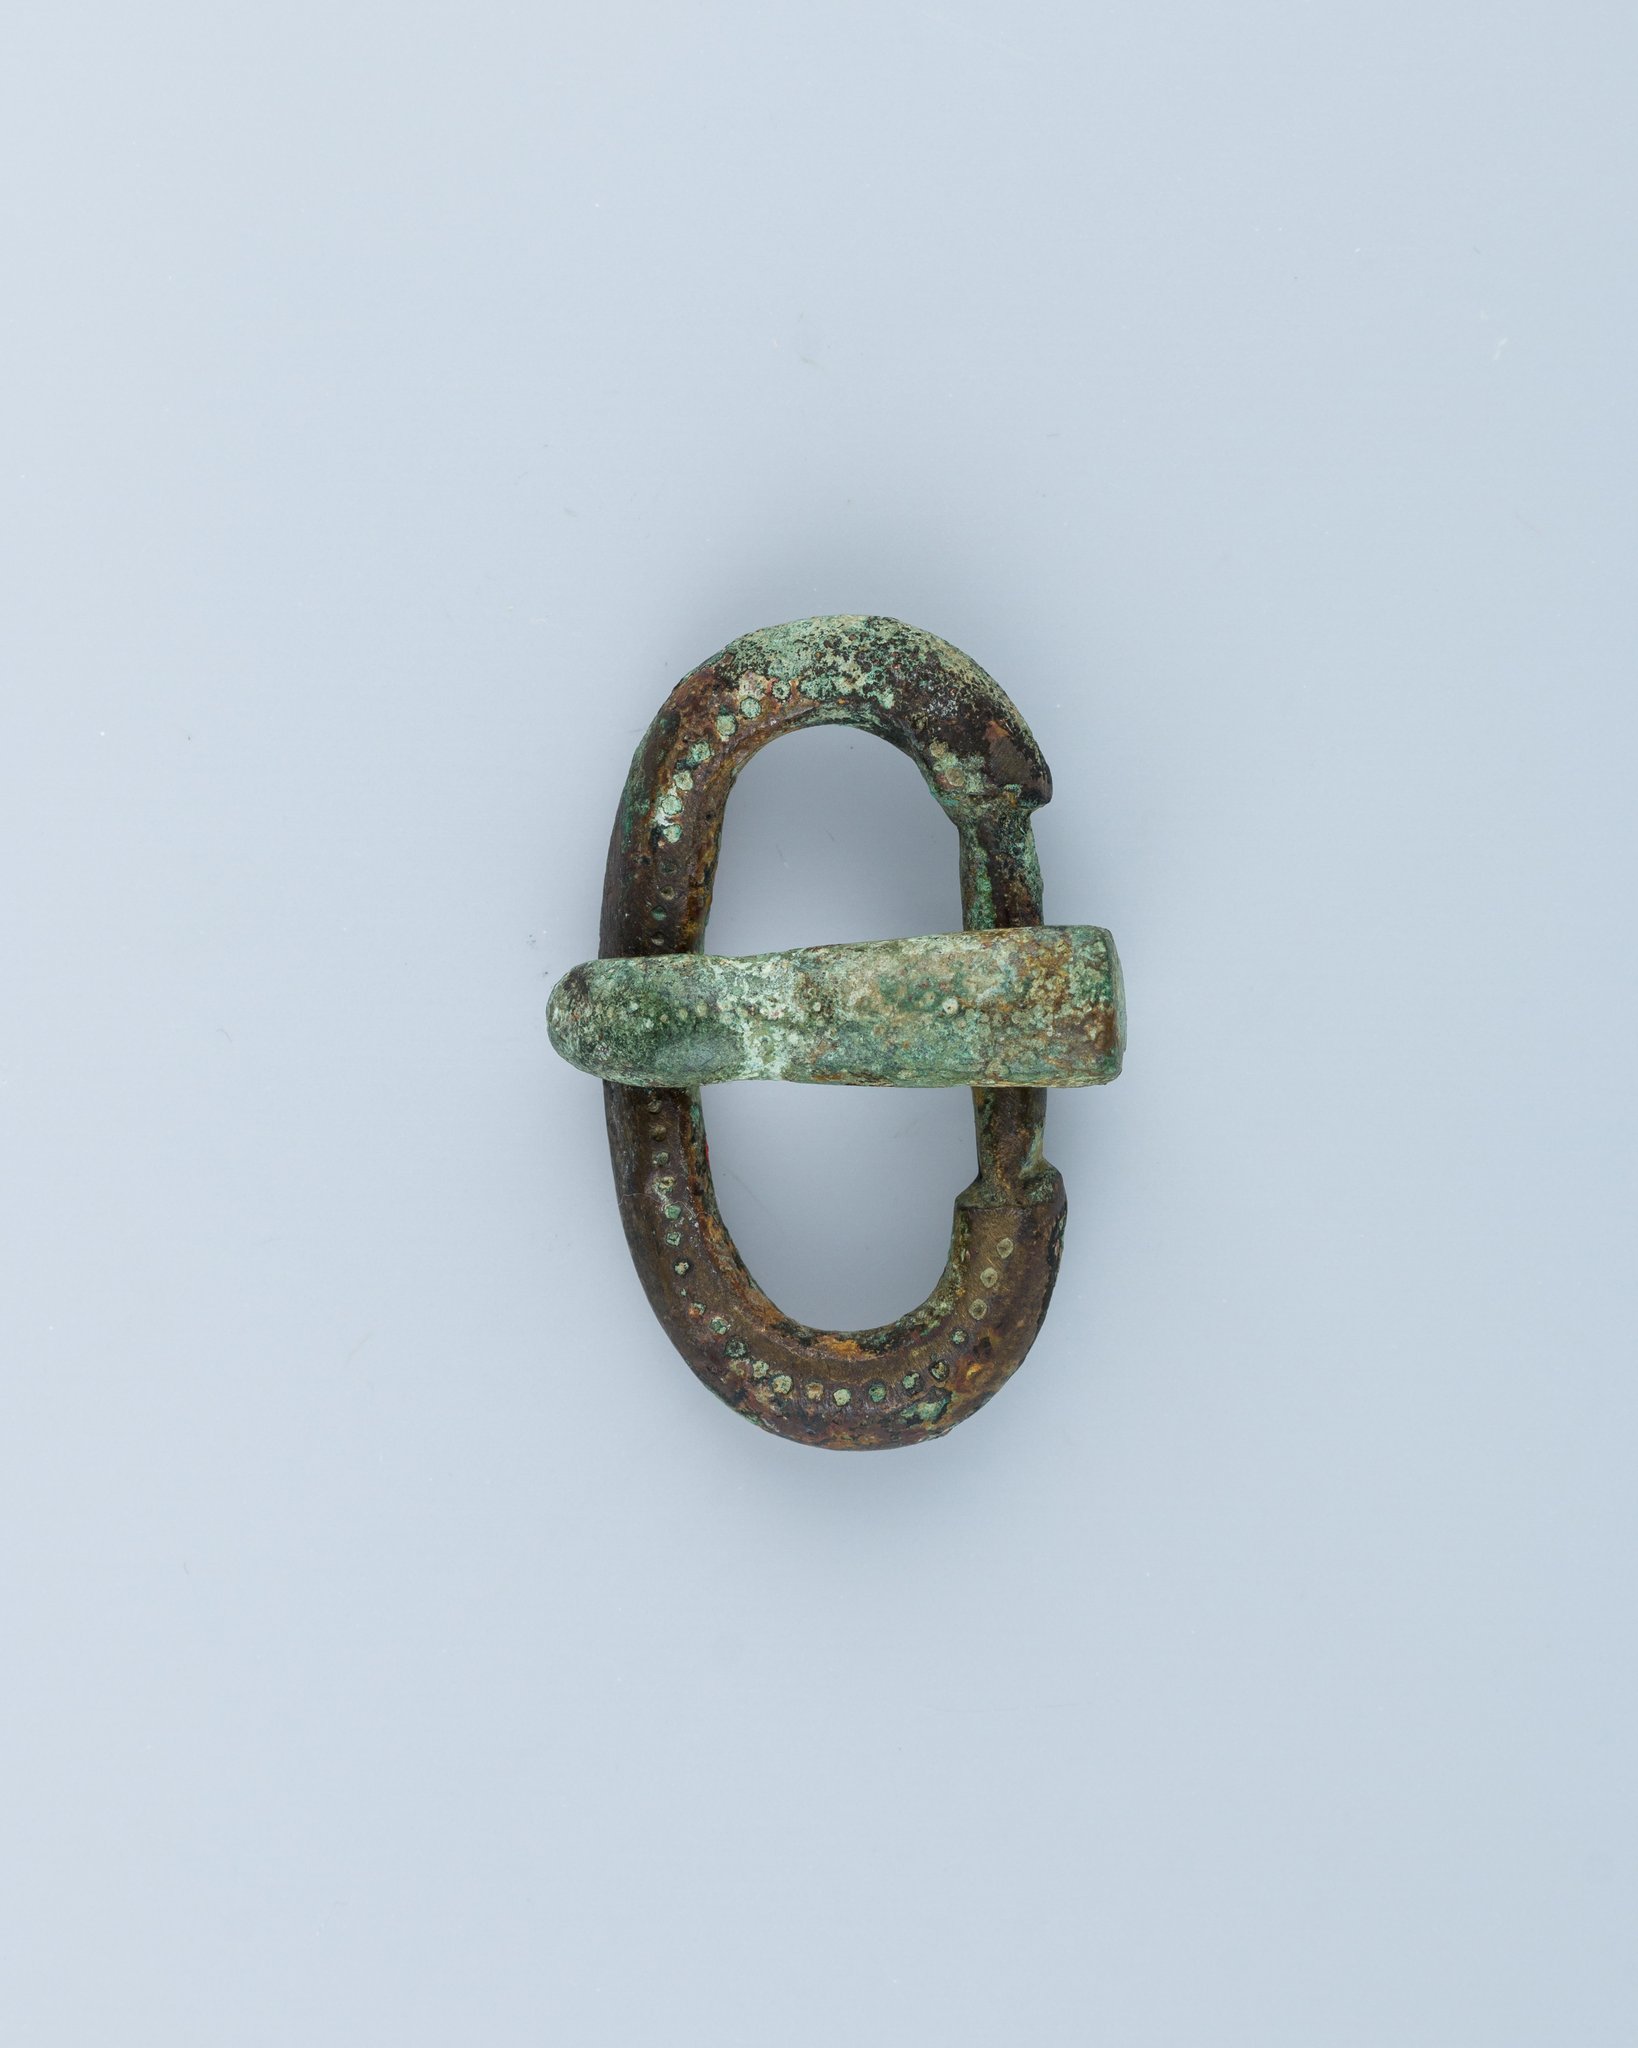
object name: buckle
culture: ibero-roman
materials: bronze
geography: spain or portugal